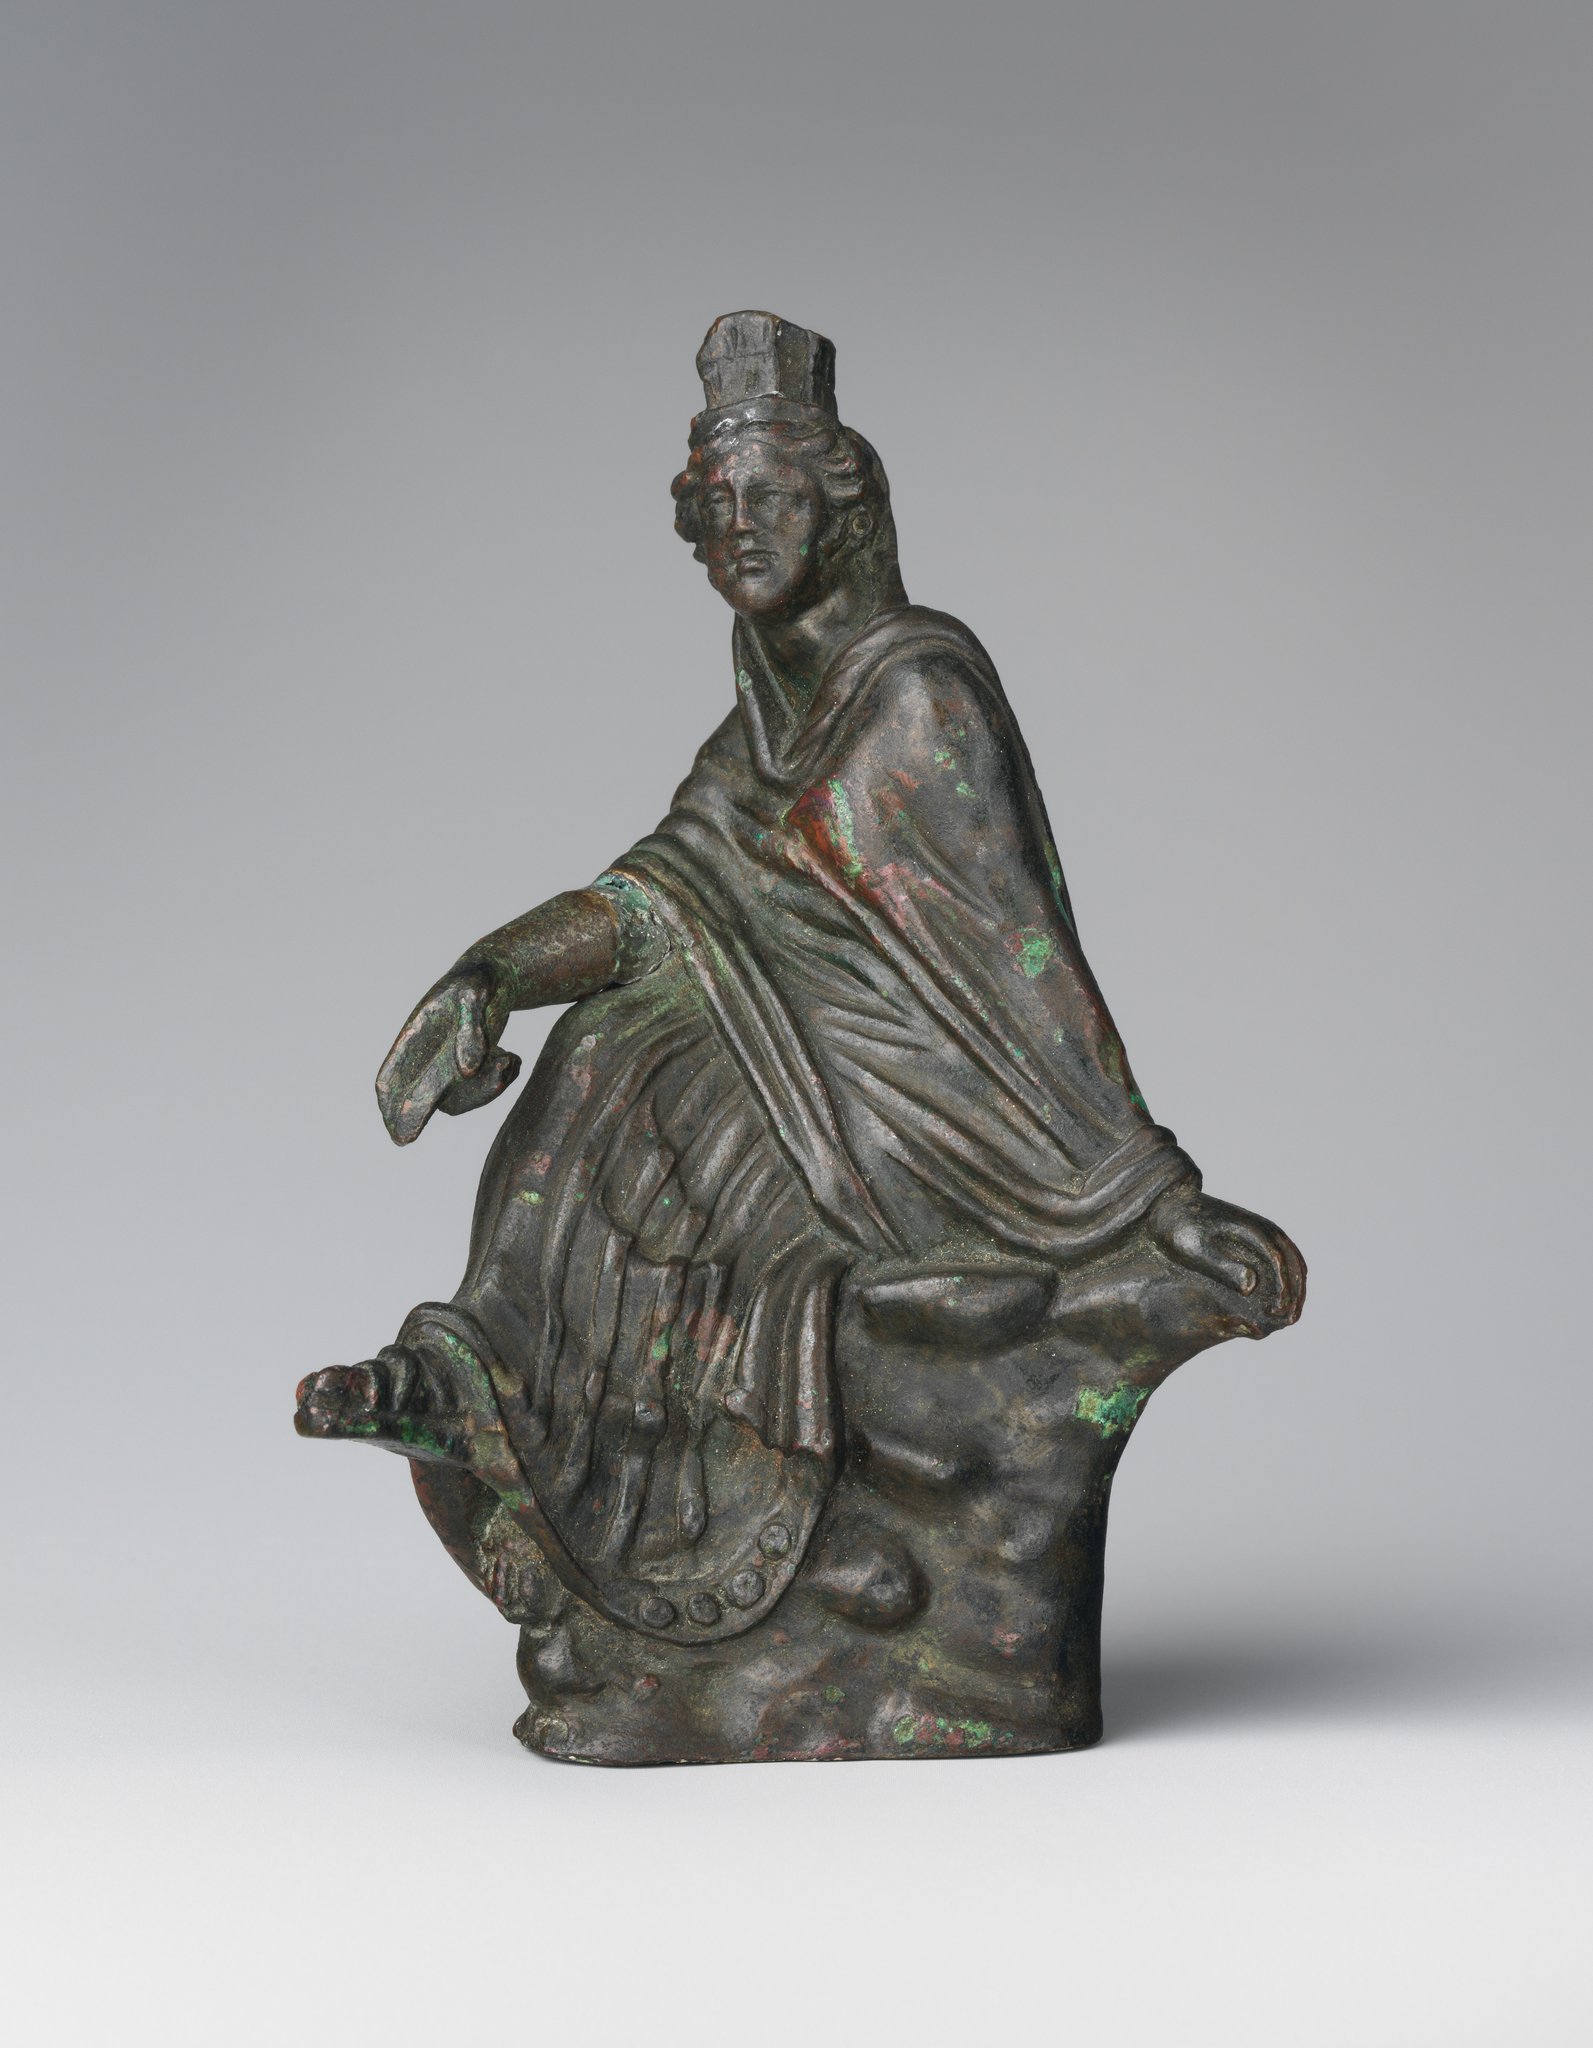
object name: statuette of tyche of antioch antiochia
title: Bronze statuette of Tyche (Good Fortune)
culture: roman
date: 1-100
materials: bronze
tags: women